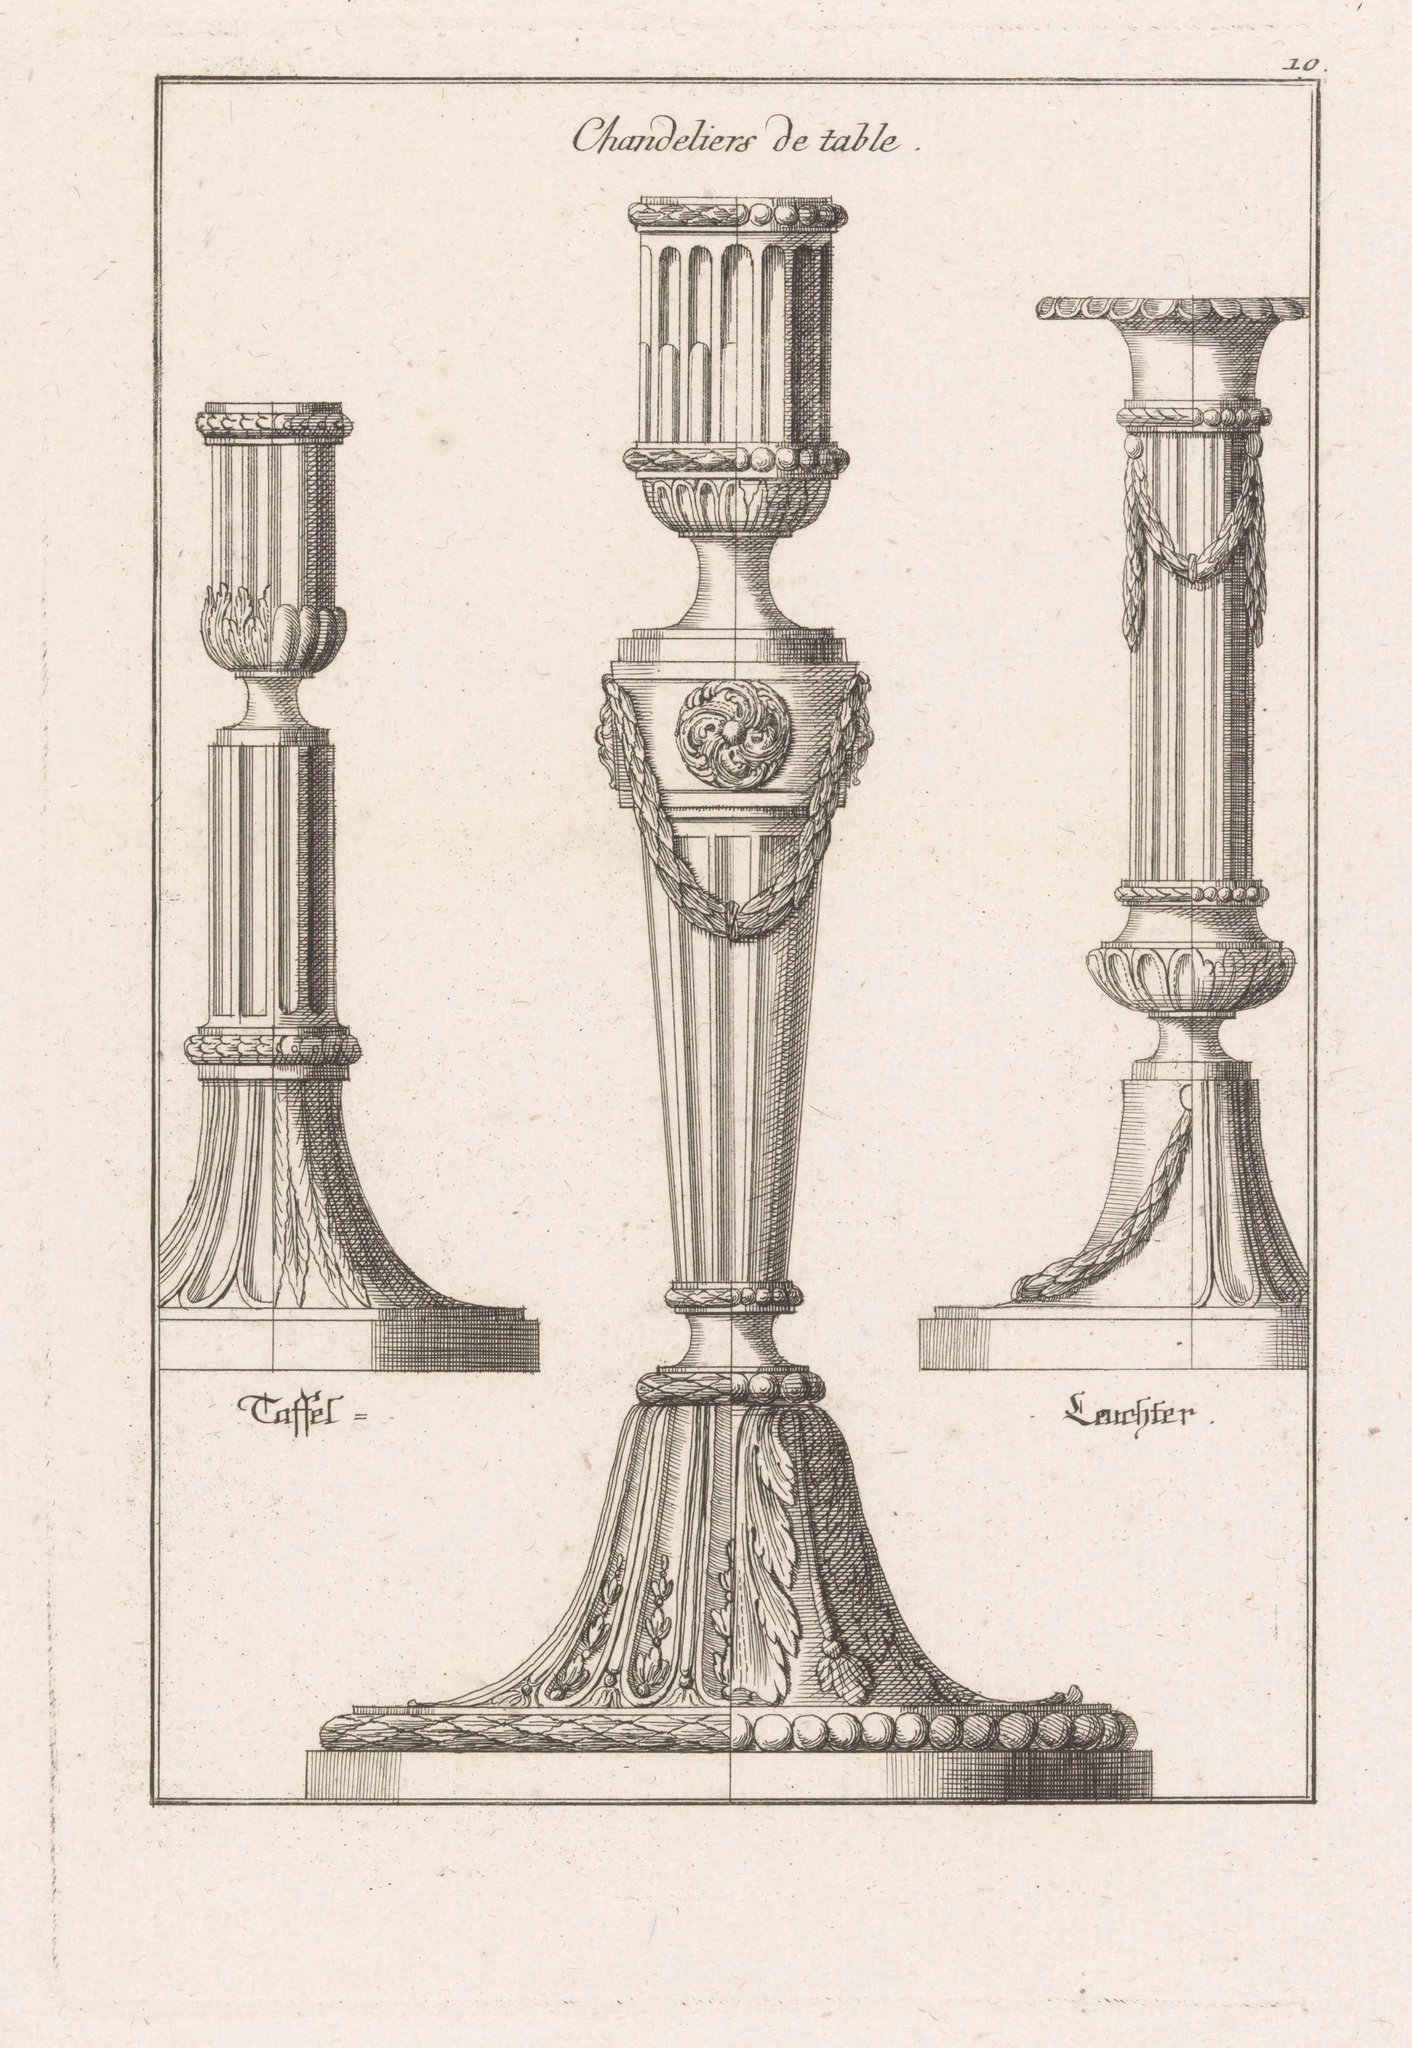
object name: print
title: Desseins de diverses pièces d'argenterie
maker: franz xaver habermann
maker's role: draughtsman, print maker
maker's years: 1721-1796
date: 1731-1796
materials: paper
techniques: etching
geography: germany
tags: chandelier, candelabrum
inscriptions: collector's mark: Lugt 2760, collector's mark: Lugt 2228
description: Drie tafelkandelaars met bladmotieven en ornamenten.